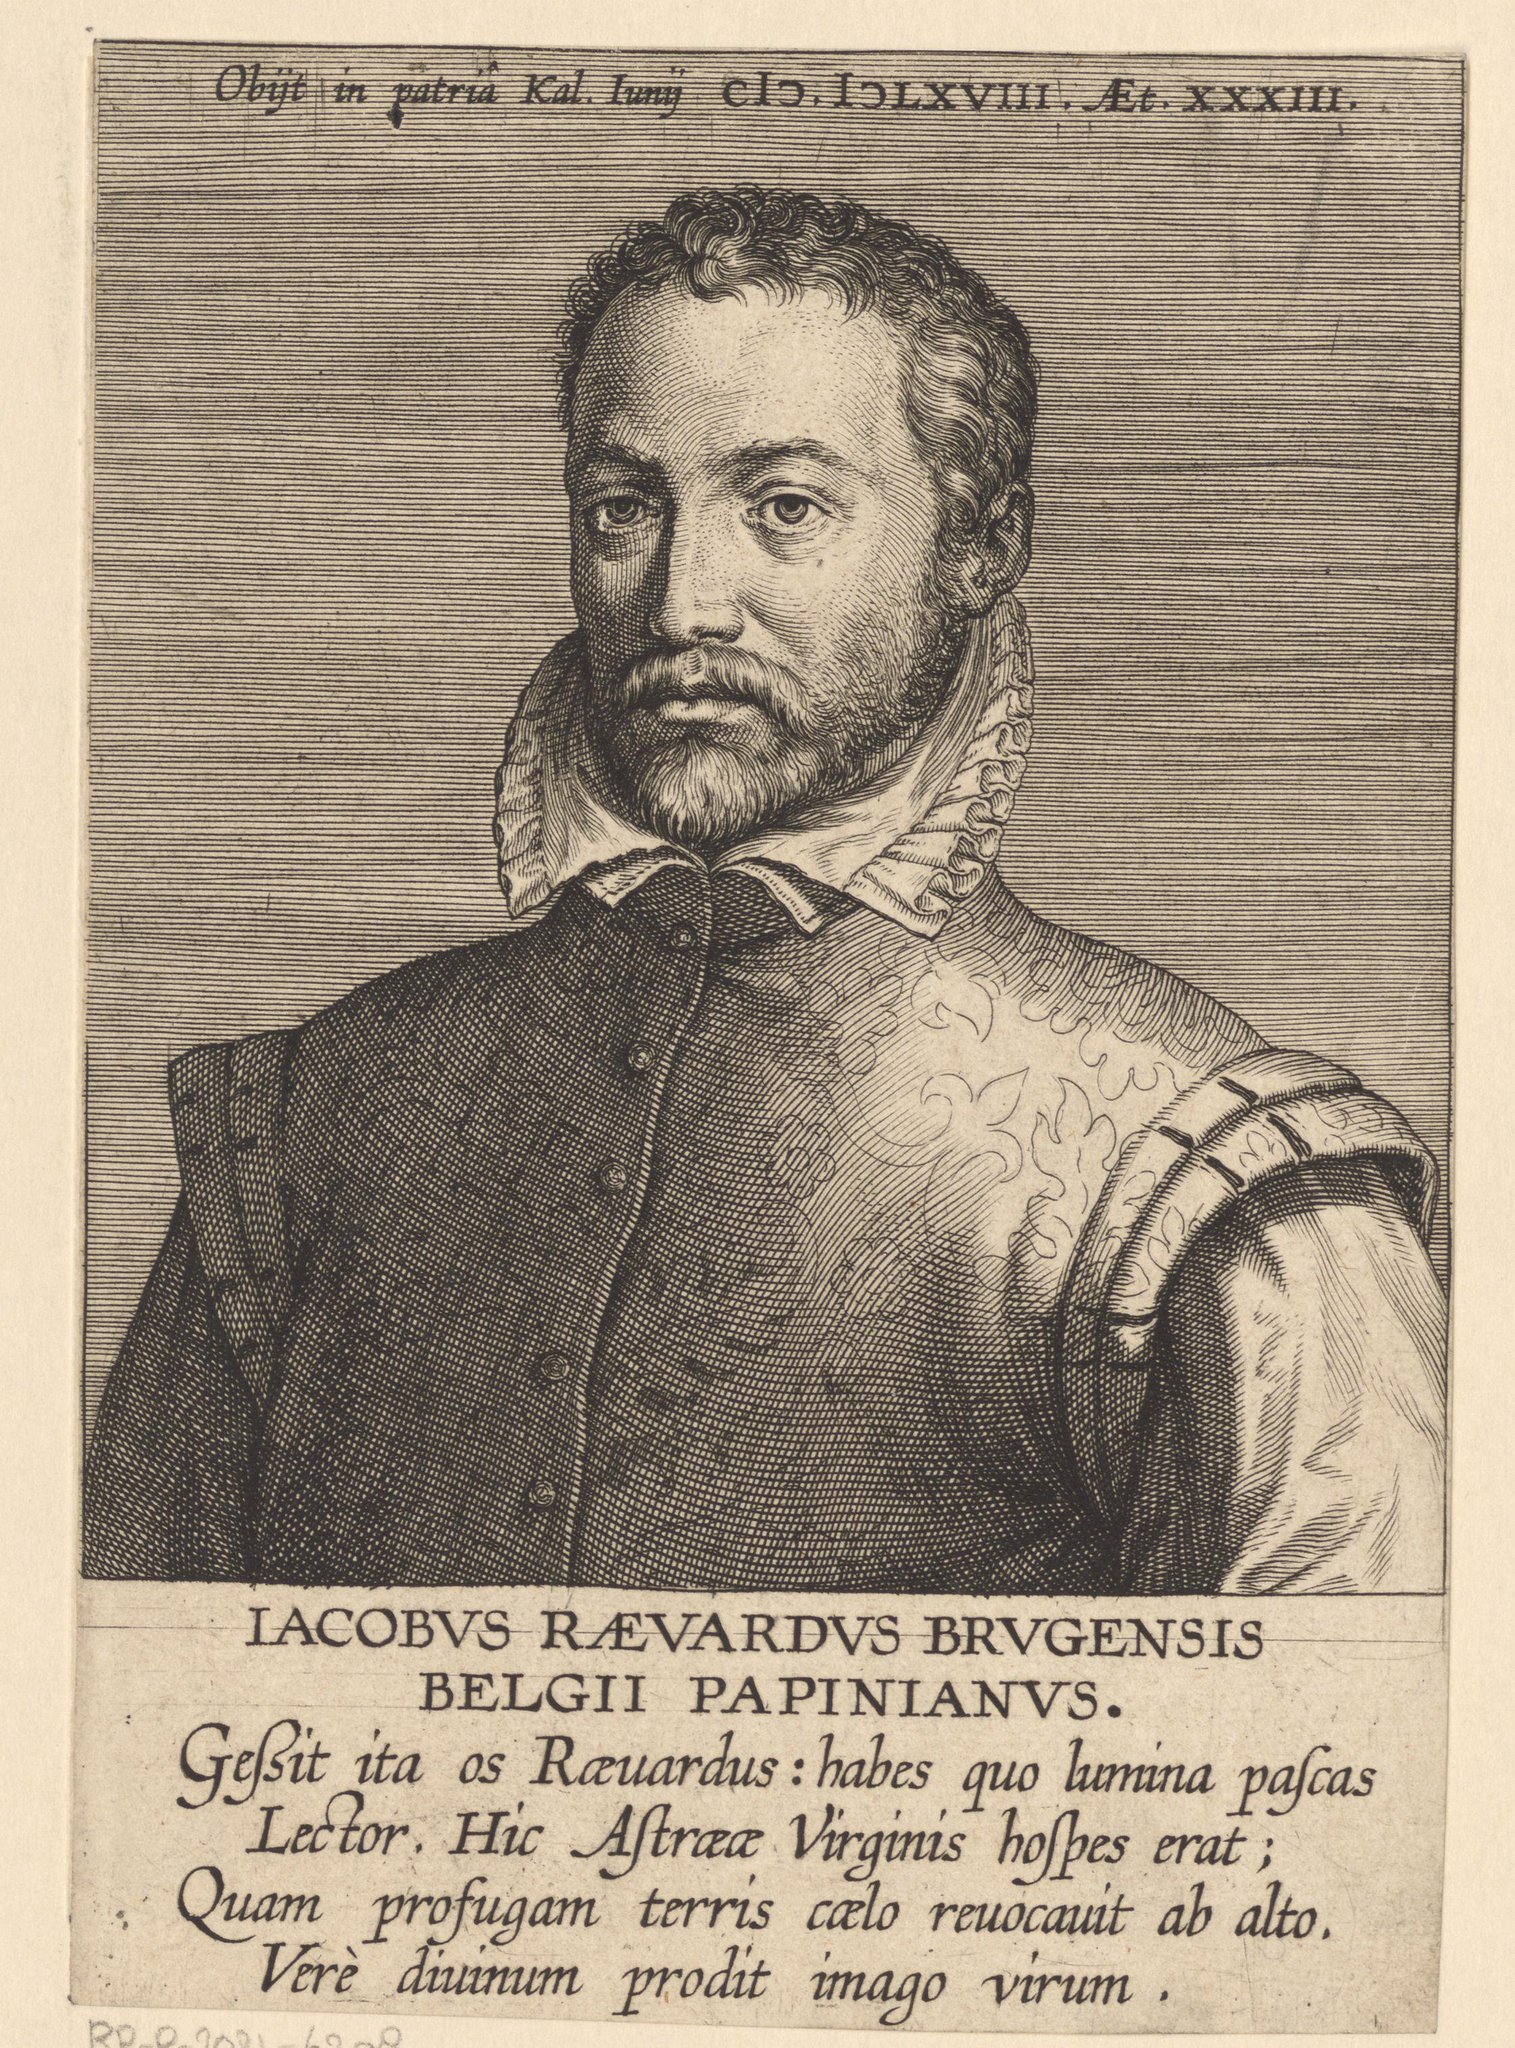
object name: print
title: Illustrium Galliae Belgicae scriptorum icones et elogi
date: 1604-1608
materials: paper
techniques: engraving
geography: antwerp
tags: historical persons